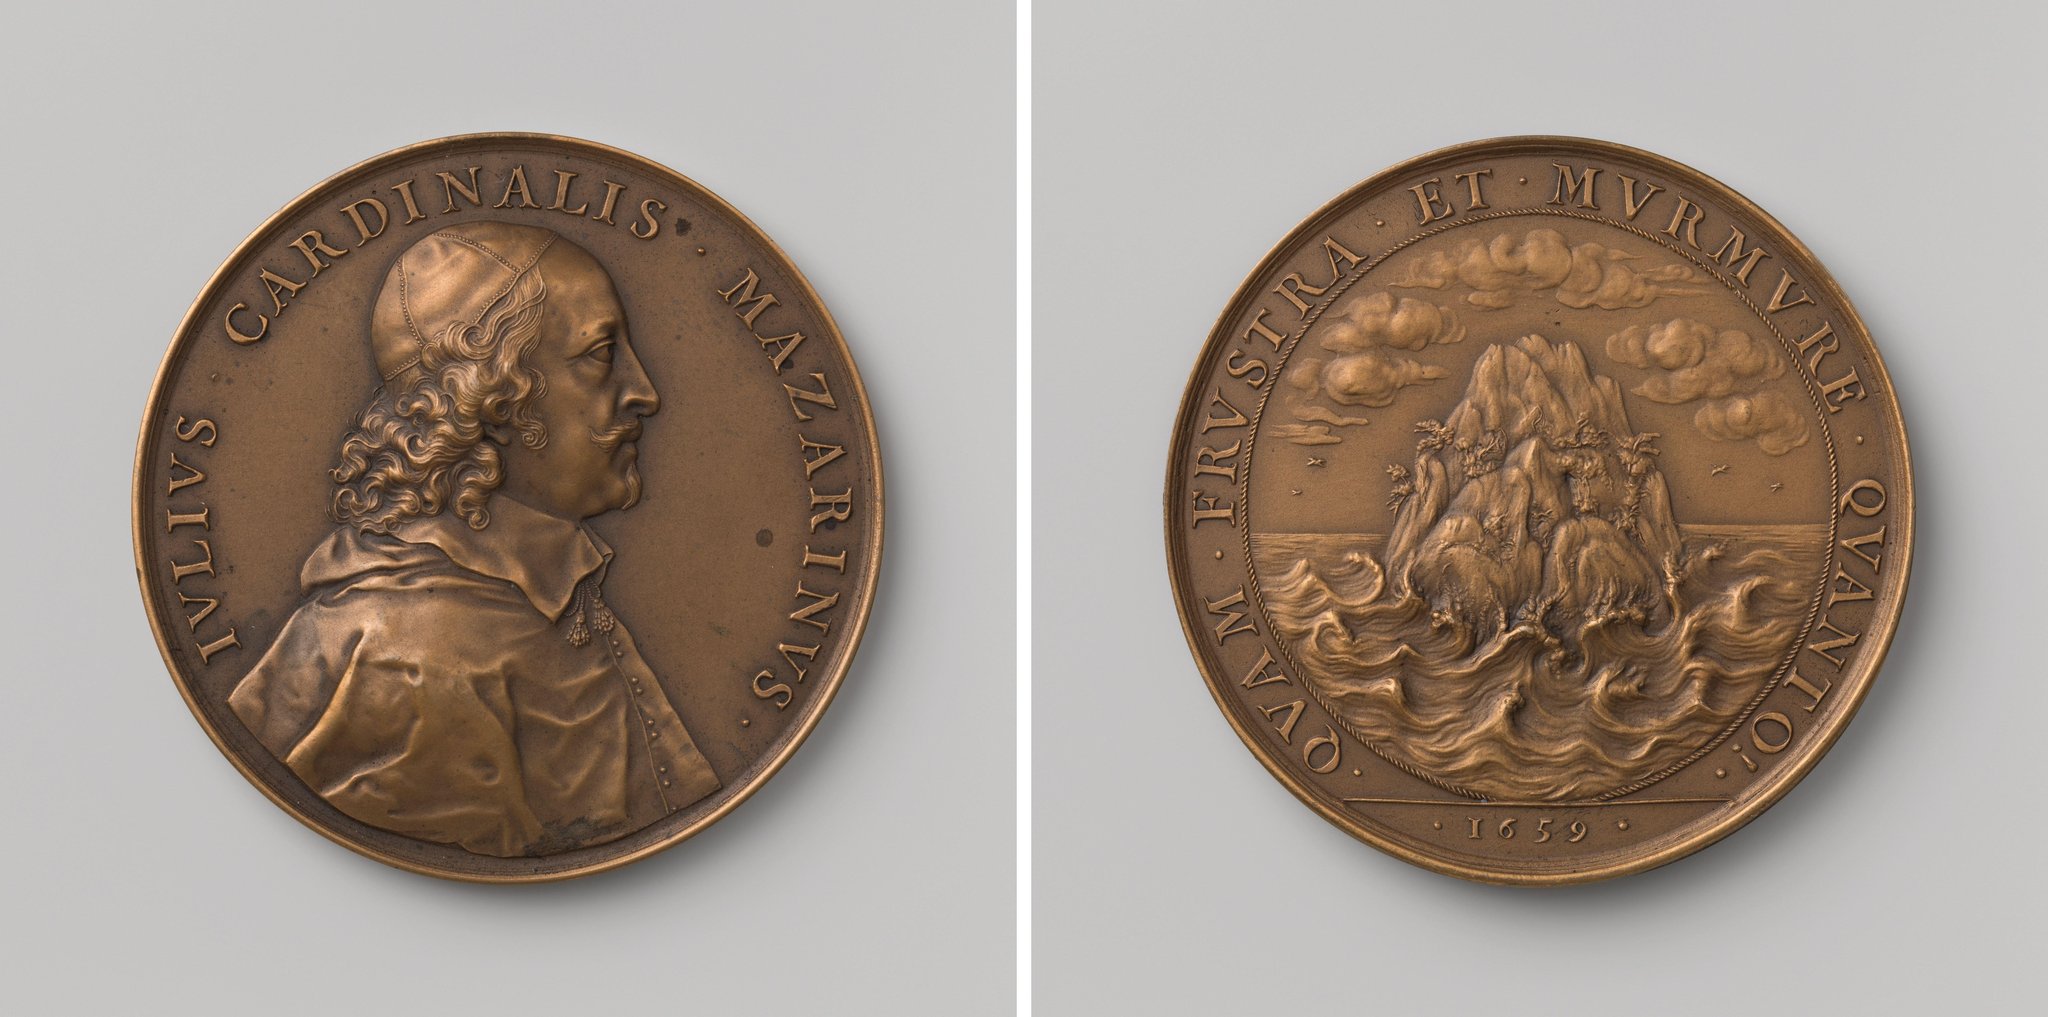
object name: copy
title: Kardinaal de Mazarin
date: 1659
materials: bronze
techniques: striking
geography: paris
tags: jules mazarin, cardinal, historical persons, france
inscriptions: date: ‘1659’, circumscription: ‘QVUM . FRVSTRA . ET . MVRMVRE . QVANTO!!’, circumscription: ‘IVL ' IVS . CARDINALIS . MAZARINVS’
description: Bronzen penning. Voorzijde: borststuk man, in profiel naar rechts. Hij draagt en mozetta, een platte kraag met twee akertjes en op het afhangende krullende haar een kalotje binnen omschrift. Keerzijde: rots waarop vogels neerstrijken, temidden van zware golven, hemel is bewolkt binnen omschrift; afsnede: jaartal.